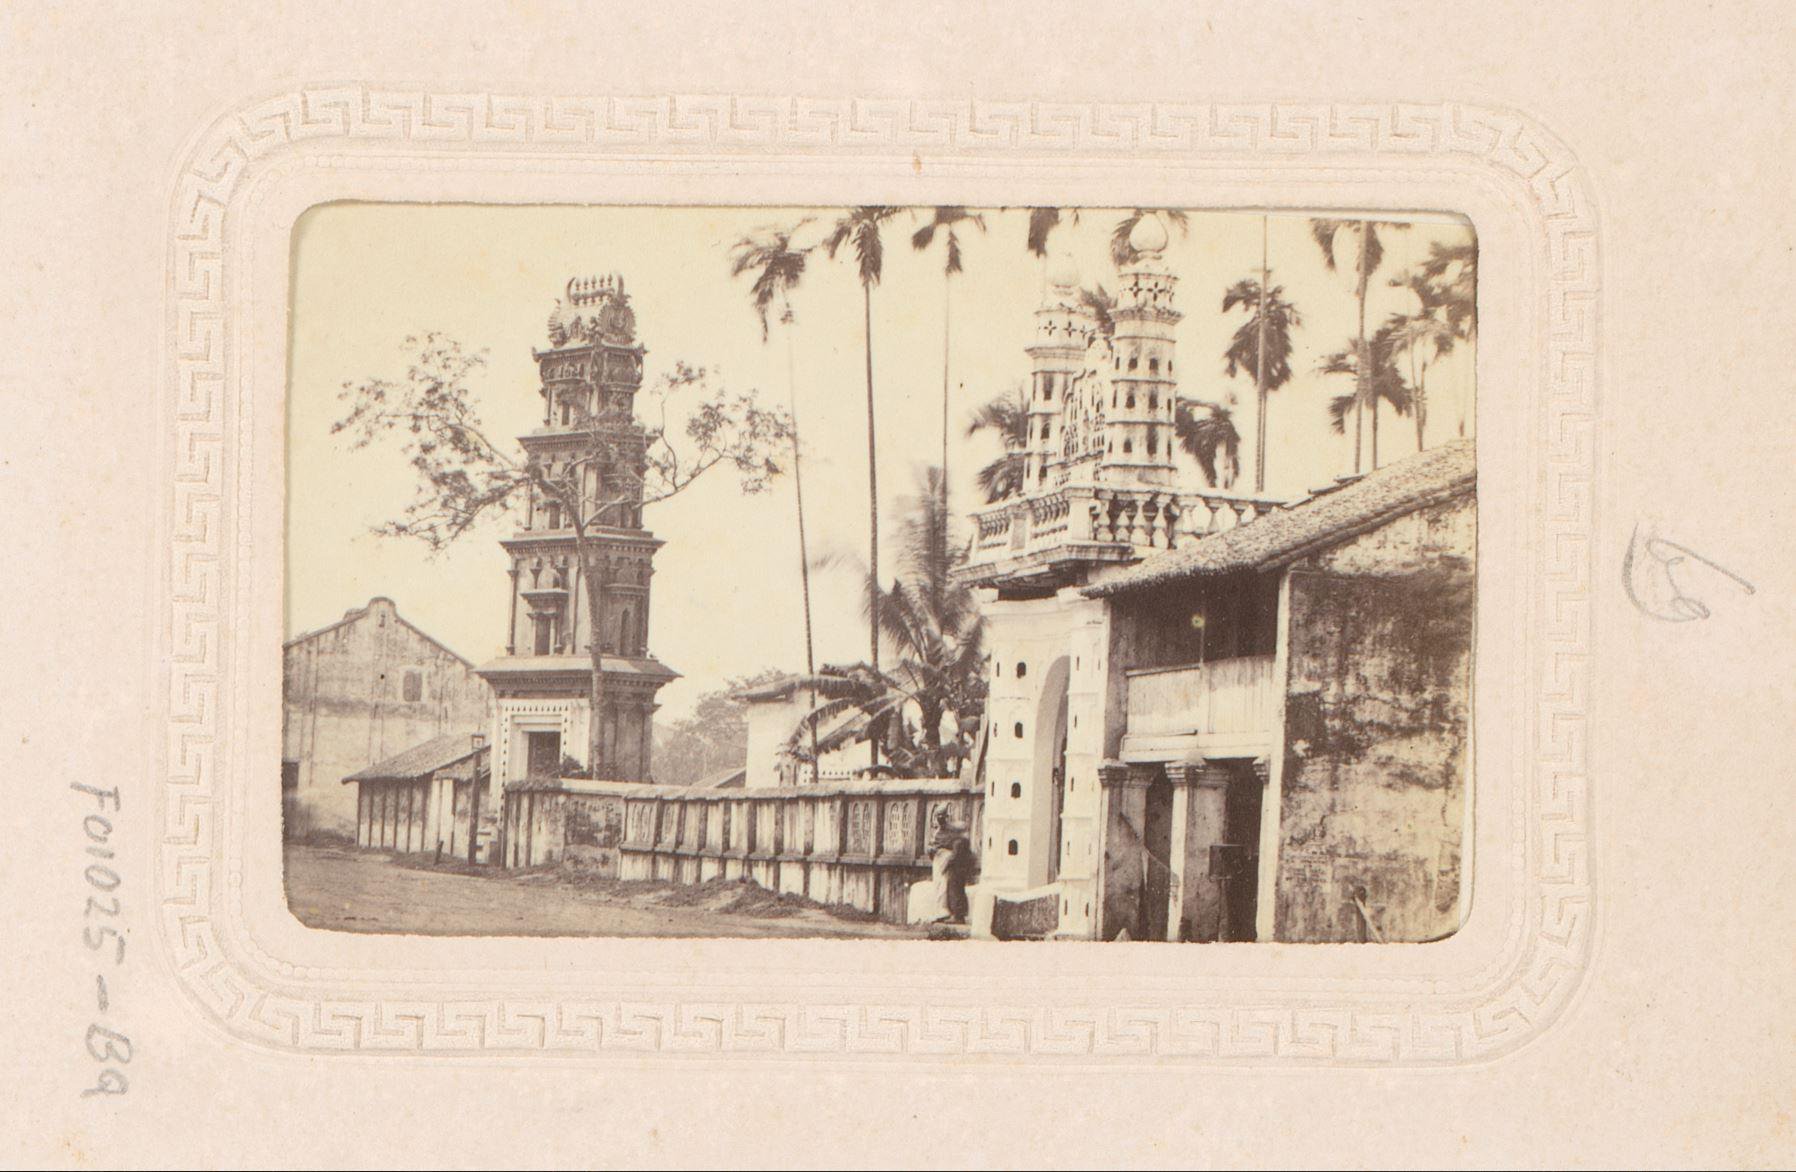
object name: carte de visite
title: Ingangen van een hindoeïstische tempel en een moskee te Singapore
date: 1867-1880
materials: cardboard, photographic support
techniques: albumen print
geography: singapore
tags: temple, shrine ~ hinduism, buddhism, jainism, temple, shrine ~ islam, mohammedanism, singapore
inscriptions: inscription: ‘G.R. Lambert & Co./ Photographers/ Singapore’, annotation: ‘Hindoescher Tempel/ Singapore/ Mohamedanischer Tempel’, number: ‘69’